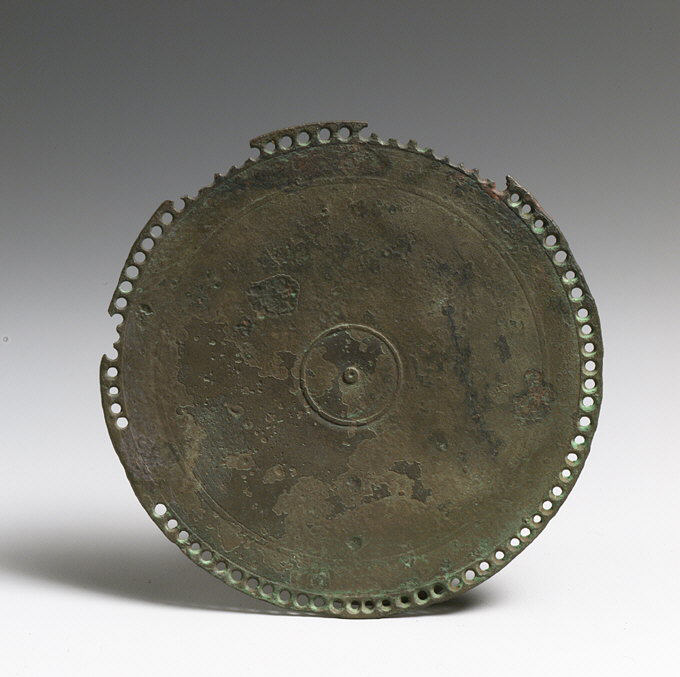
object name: mirror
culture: roman, cypriot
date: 50-400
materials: bronze